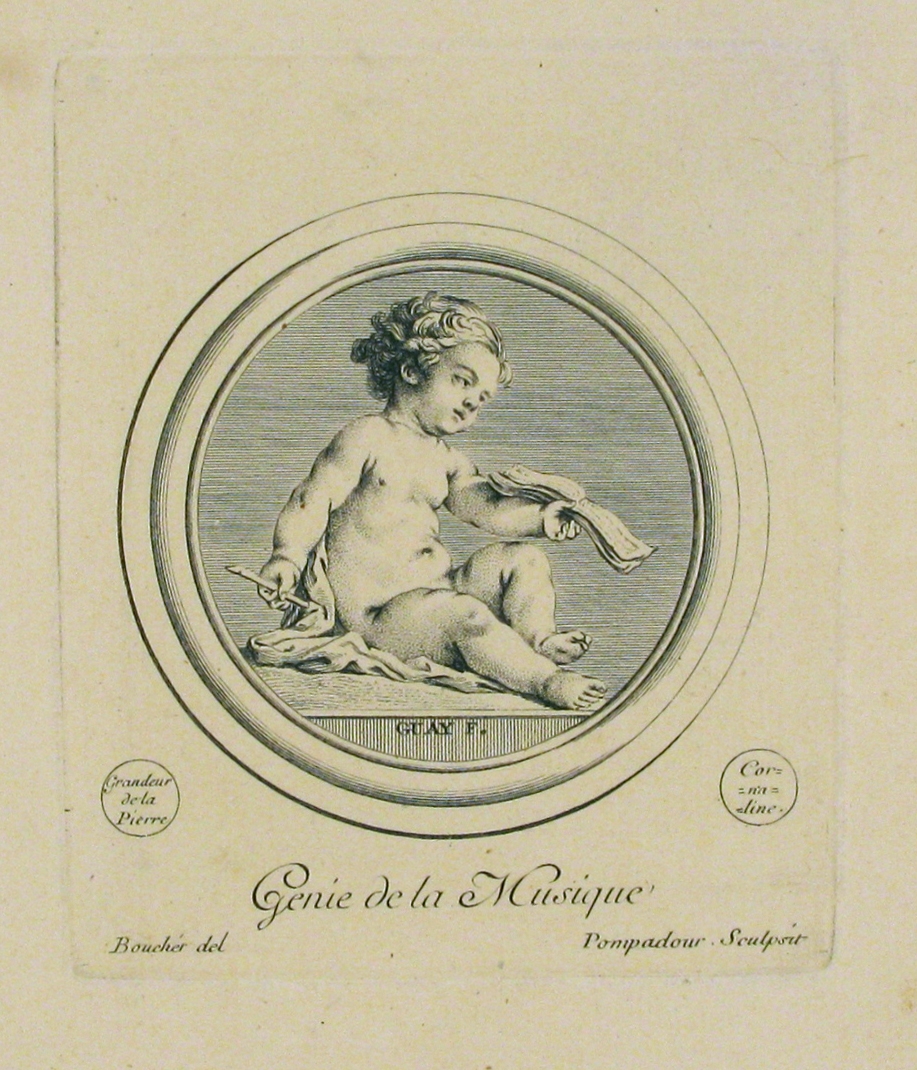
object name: print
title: Genie de la Musique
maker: madame la marquise de pompadour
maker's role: artist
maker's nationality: french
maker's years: 1721-1764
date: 1701-1800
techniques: etching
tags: children